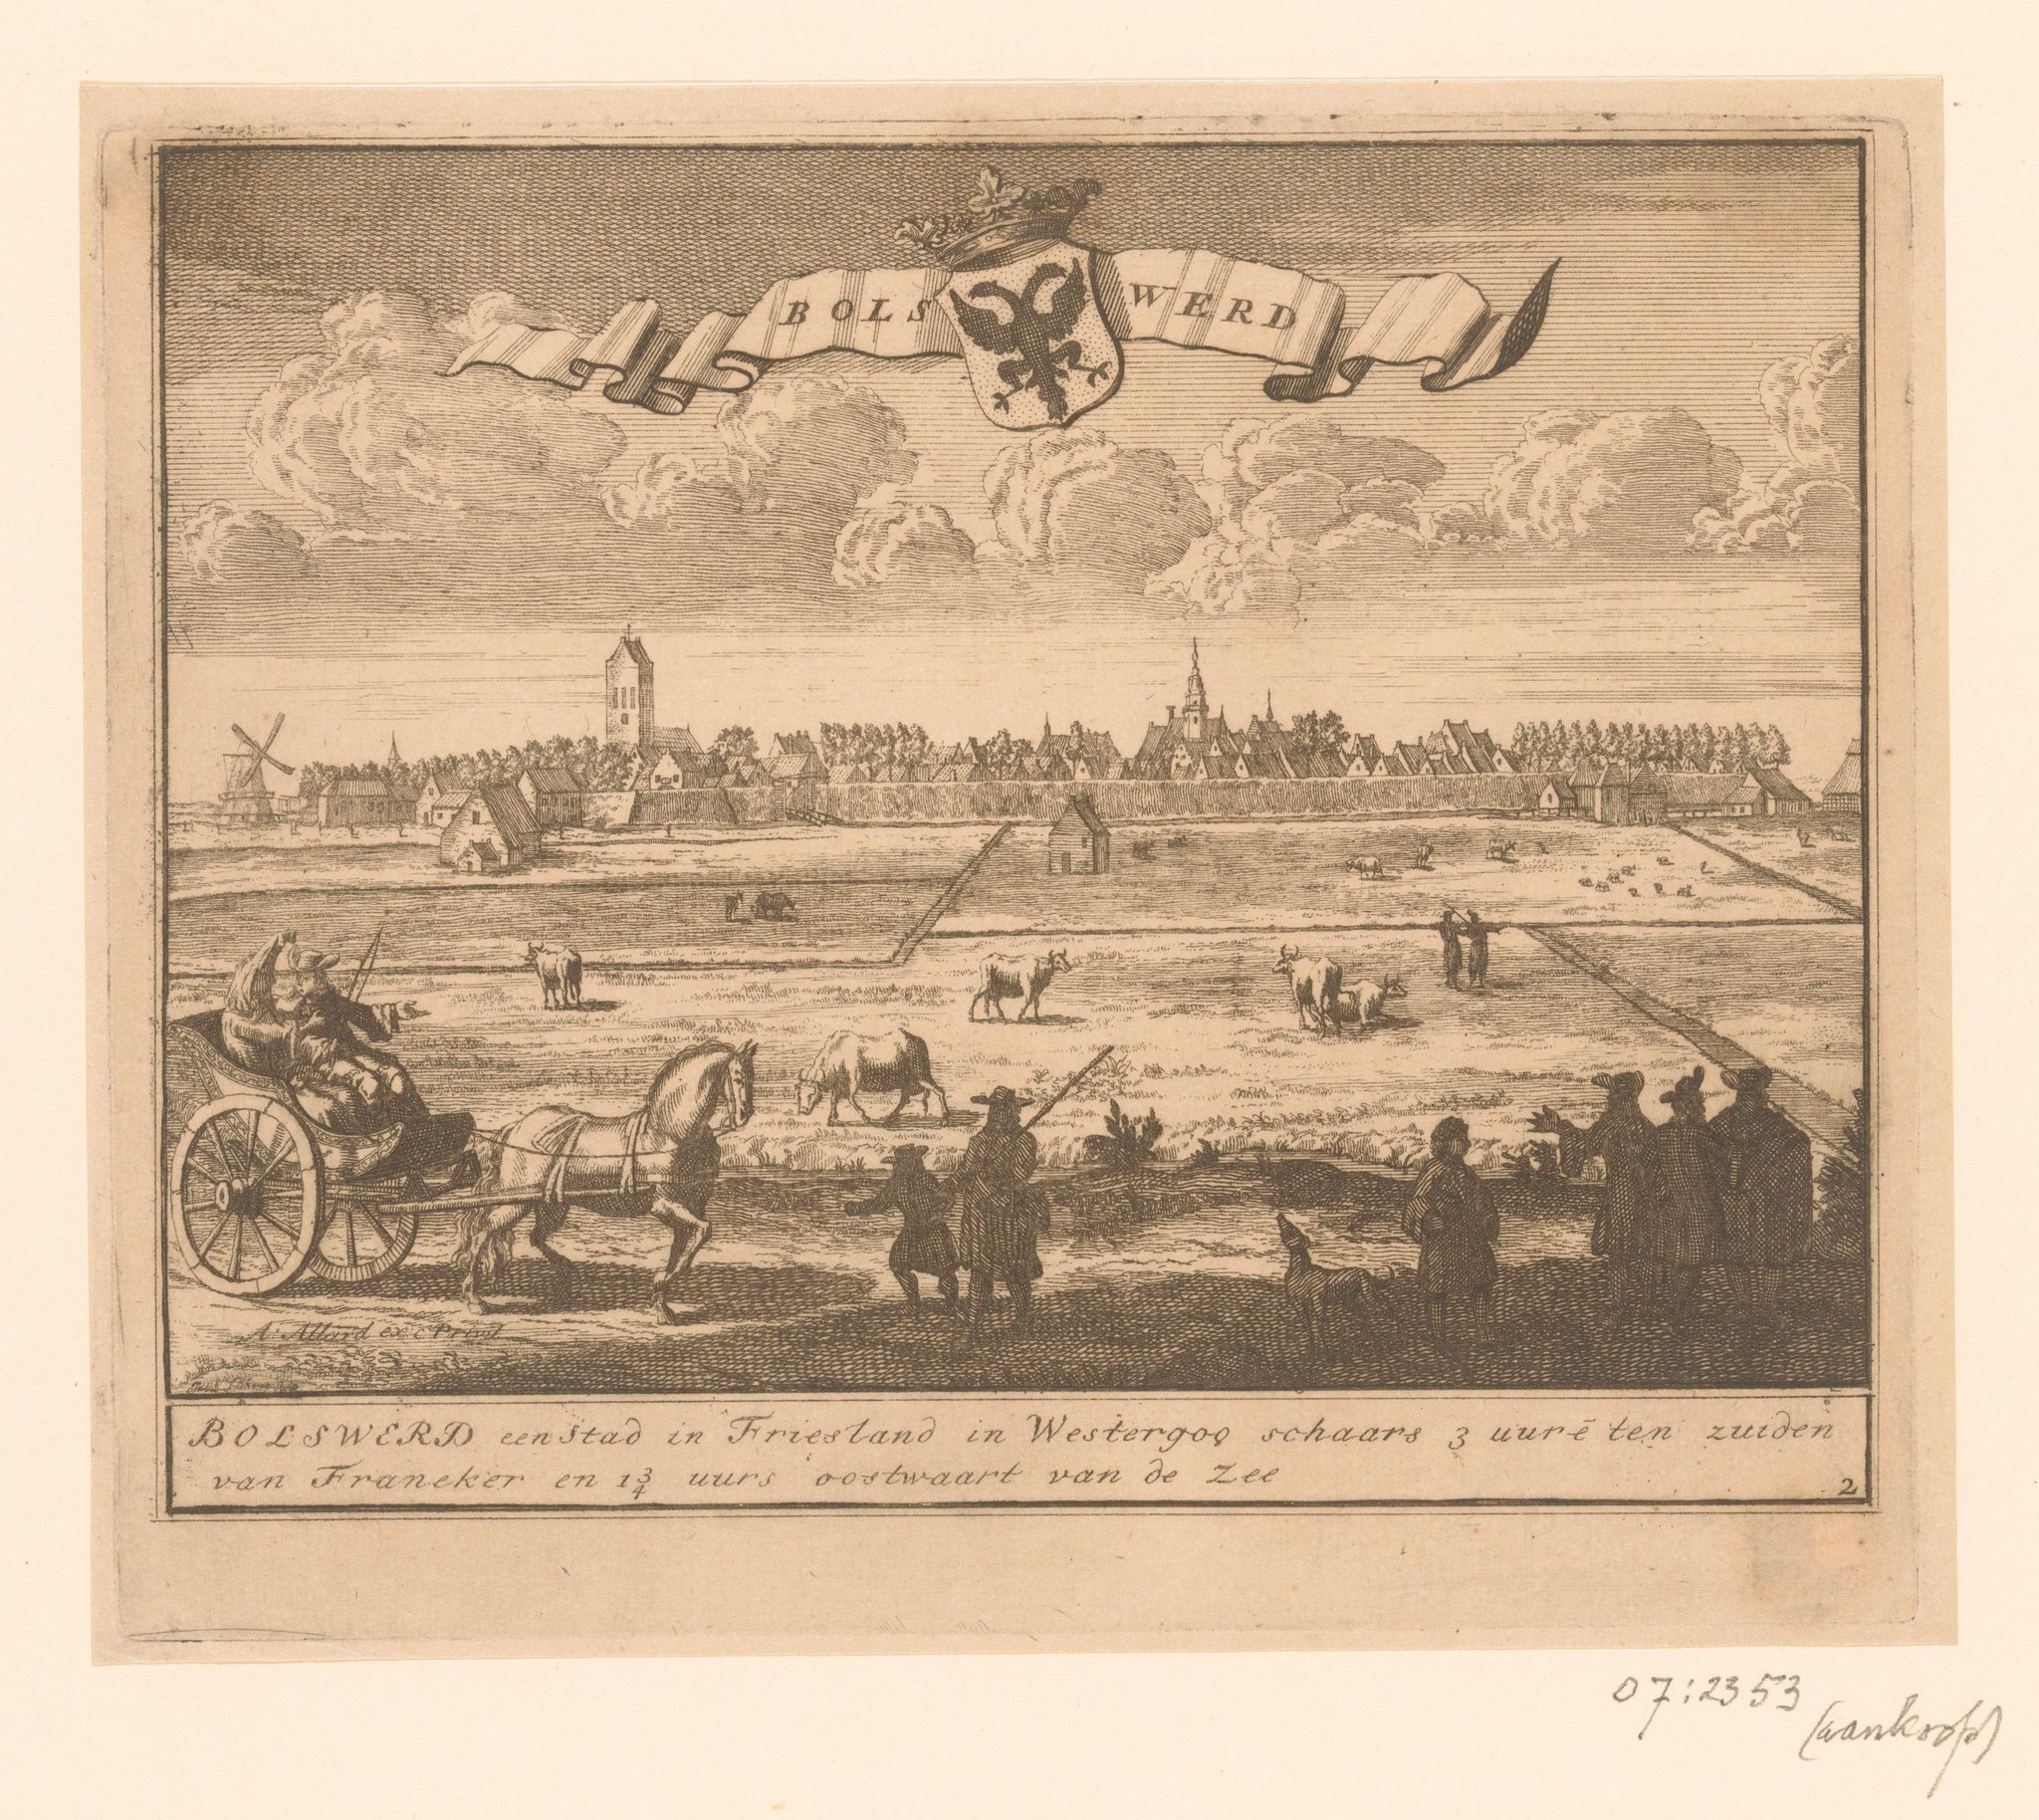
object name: print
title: Bolswerd een stad in Friesland in Westergoo schaars 3 uure ten zuiden van Franeker en 1 3/4 uurs oostwaart van de Zee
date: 1702-1767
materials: paper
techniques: etching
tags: city-view, and landscape with man-made constructions, horse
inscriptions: collector's mark: Lugt 2228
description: Prent is onderdeel van een serie van elf prenten van Friese steden, die Abraham Allard in het begin van de 18de eeuw uitgaf. Graveur van de prenten was Jacob Folkema uit Dokkum.